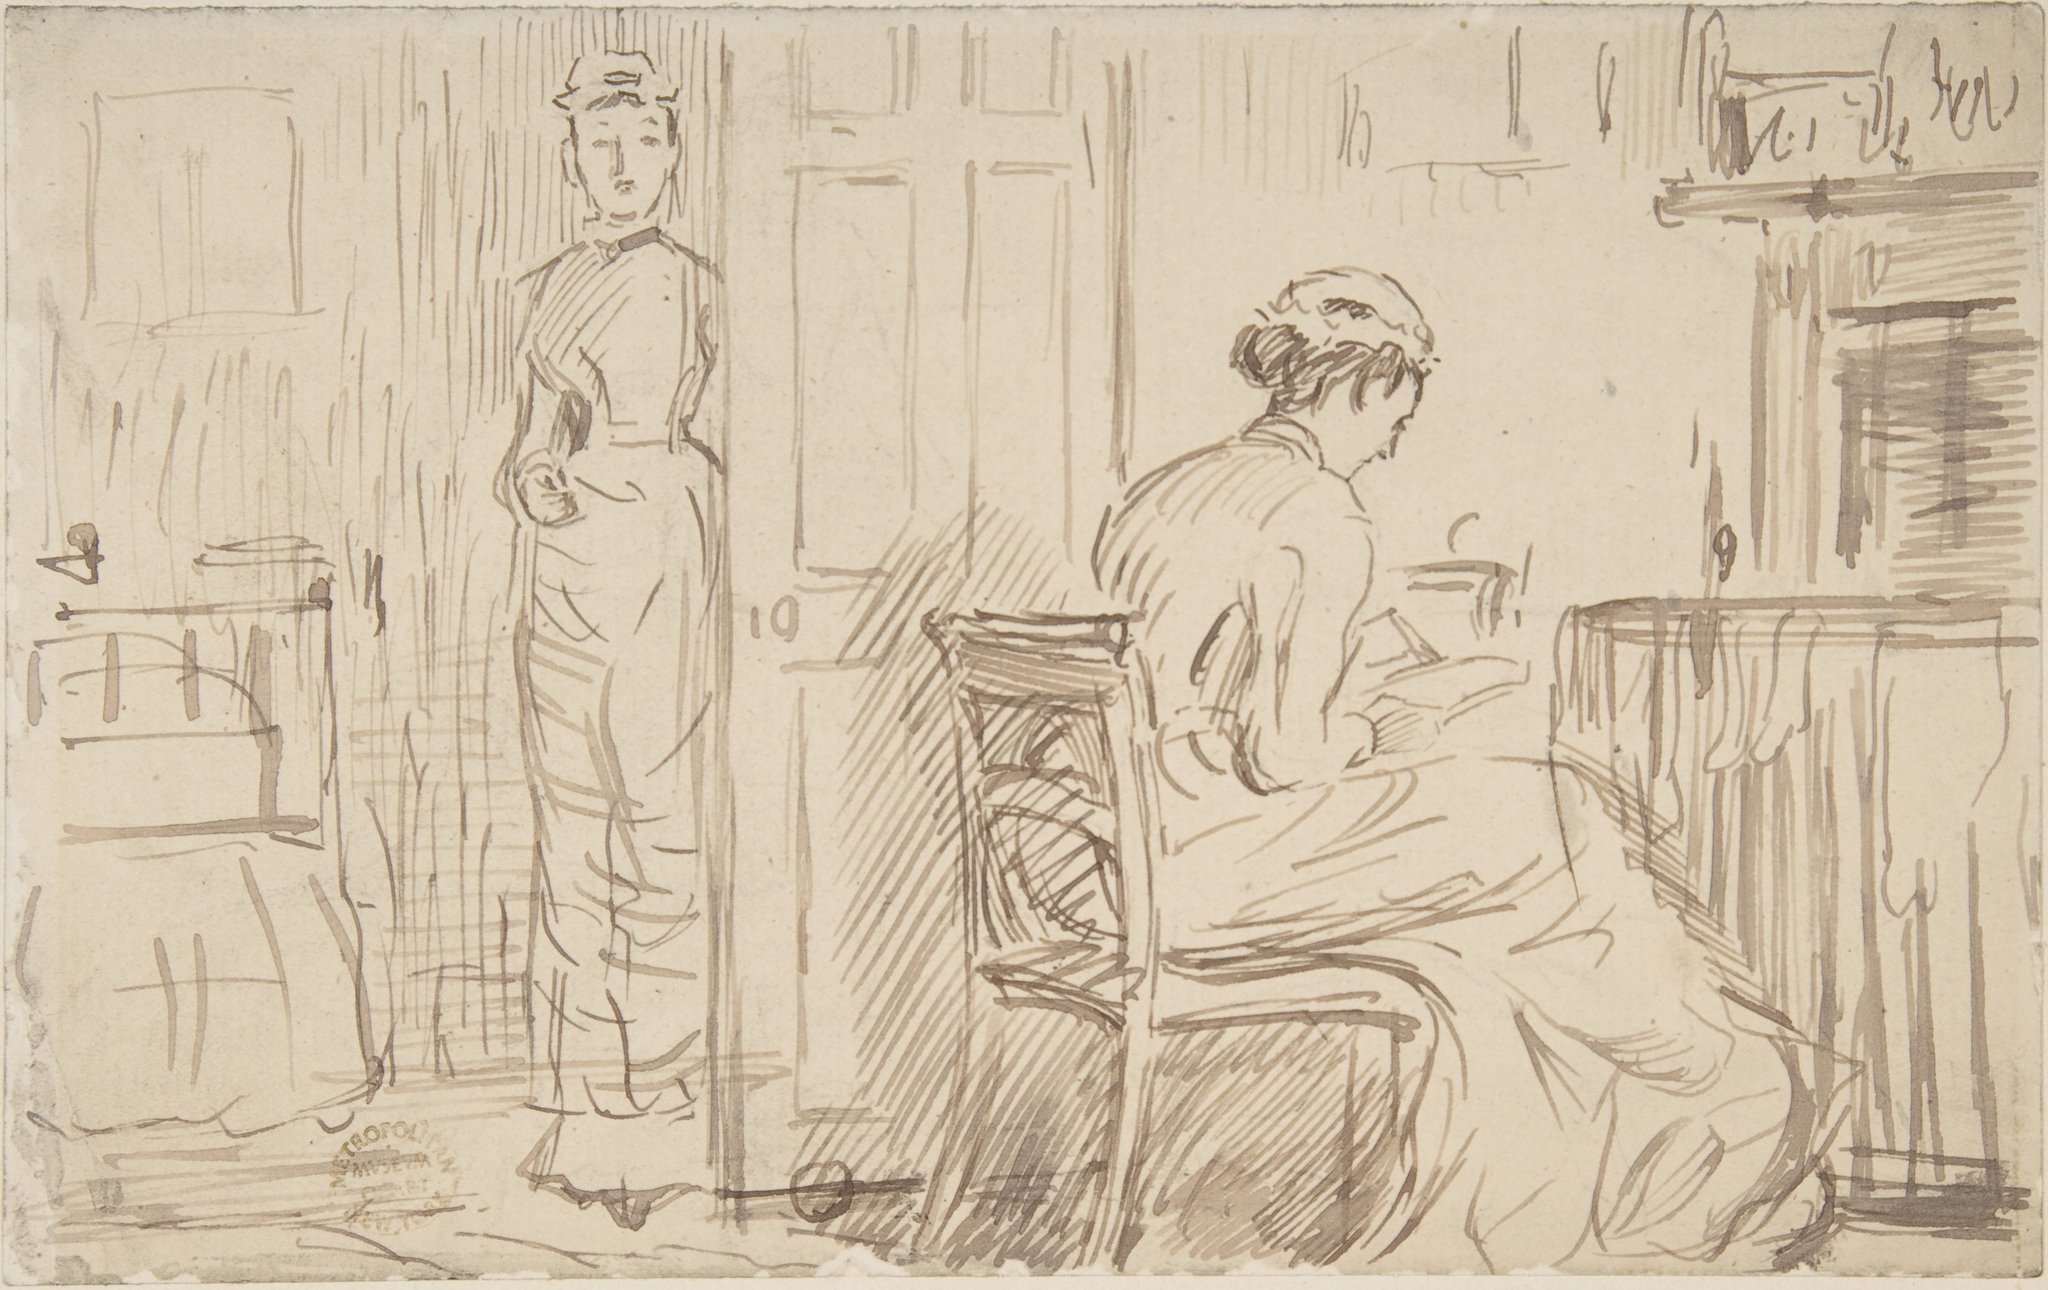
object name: drawing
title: Two Nursemaids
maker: charles samuel keene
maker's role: artist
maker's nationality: british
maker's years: 1823-1891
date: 1870-1891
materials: ink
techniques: brush, pen, wash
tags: women,reading